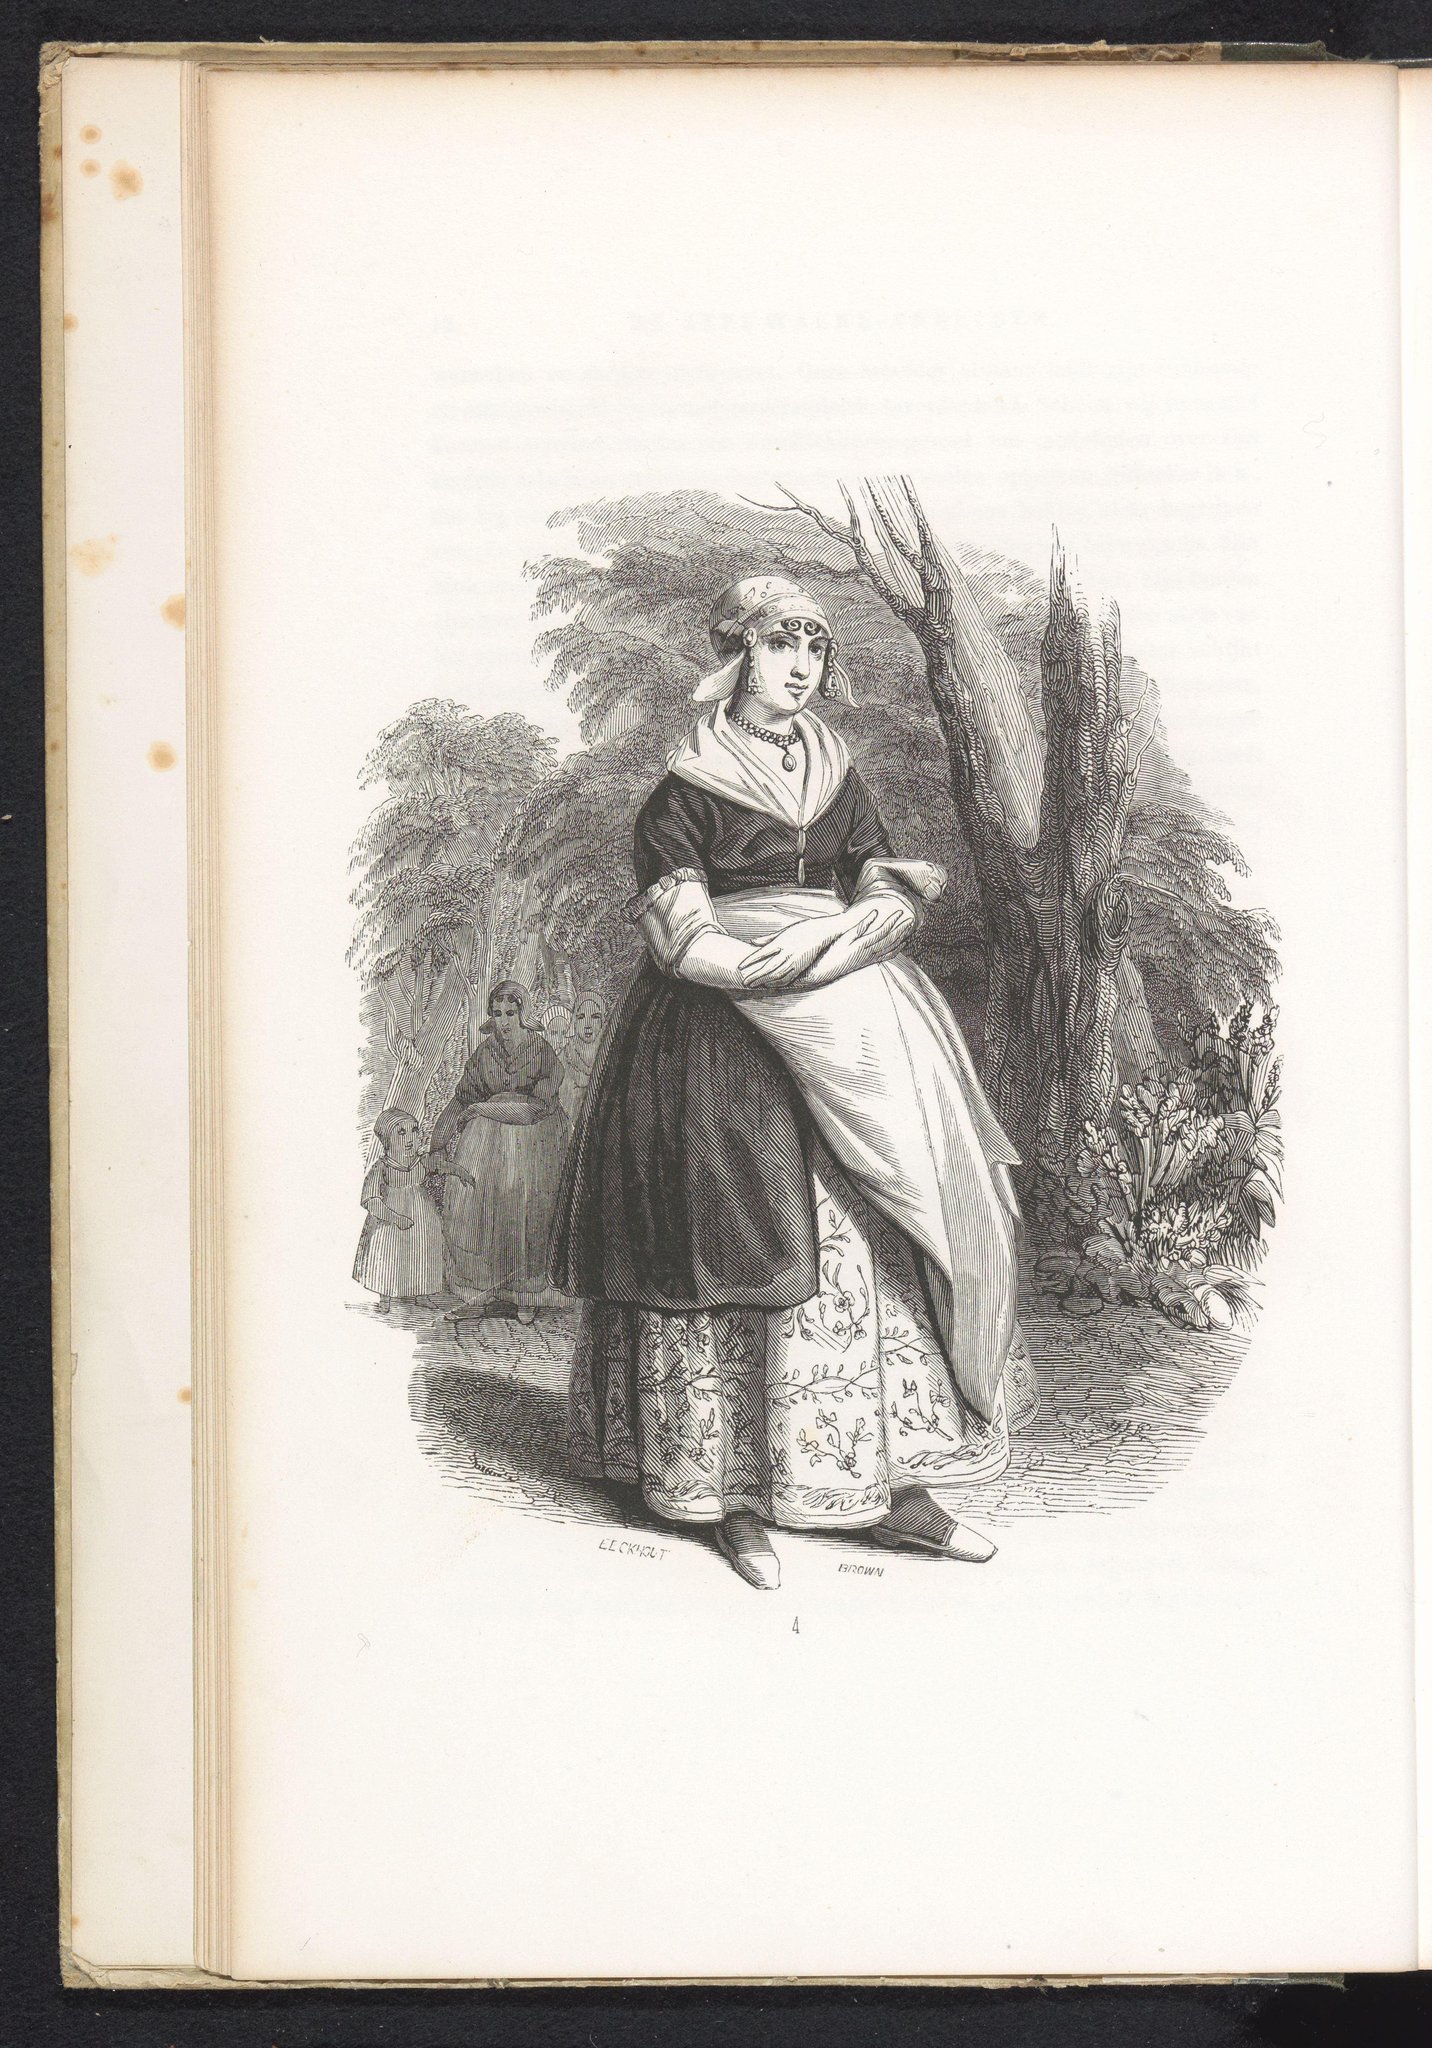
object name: print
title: De Scheveningse visvrouw, 1840-1841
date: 1841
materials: paper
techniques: letterpress printing, engraving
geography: the hague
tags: professional clothes, street-trader - bb - women engaged in trade and commerce, merchant, salesman - bb - women engaged in trade and commerce, folk costume, regional costume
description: Een staande jonge vrouw, visverkoopster uit Scheveningen. Genummerd: 4. Illustratie in het boek 'De Nederlanden: karakterschetsen, kleederdrachten, houding en voorkomen van verschillende standen', een boek met karakterschetsen, beroepen en klederdrachten van Nederlandse volkstypen uit 1841.